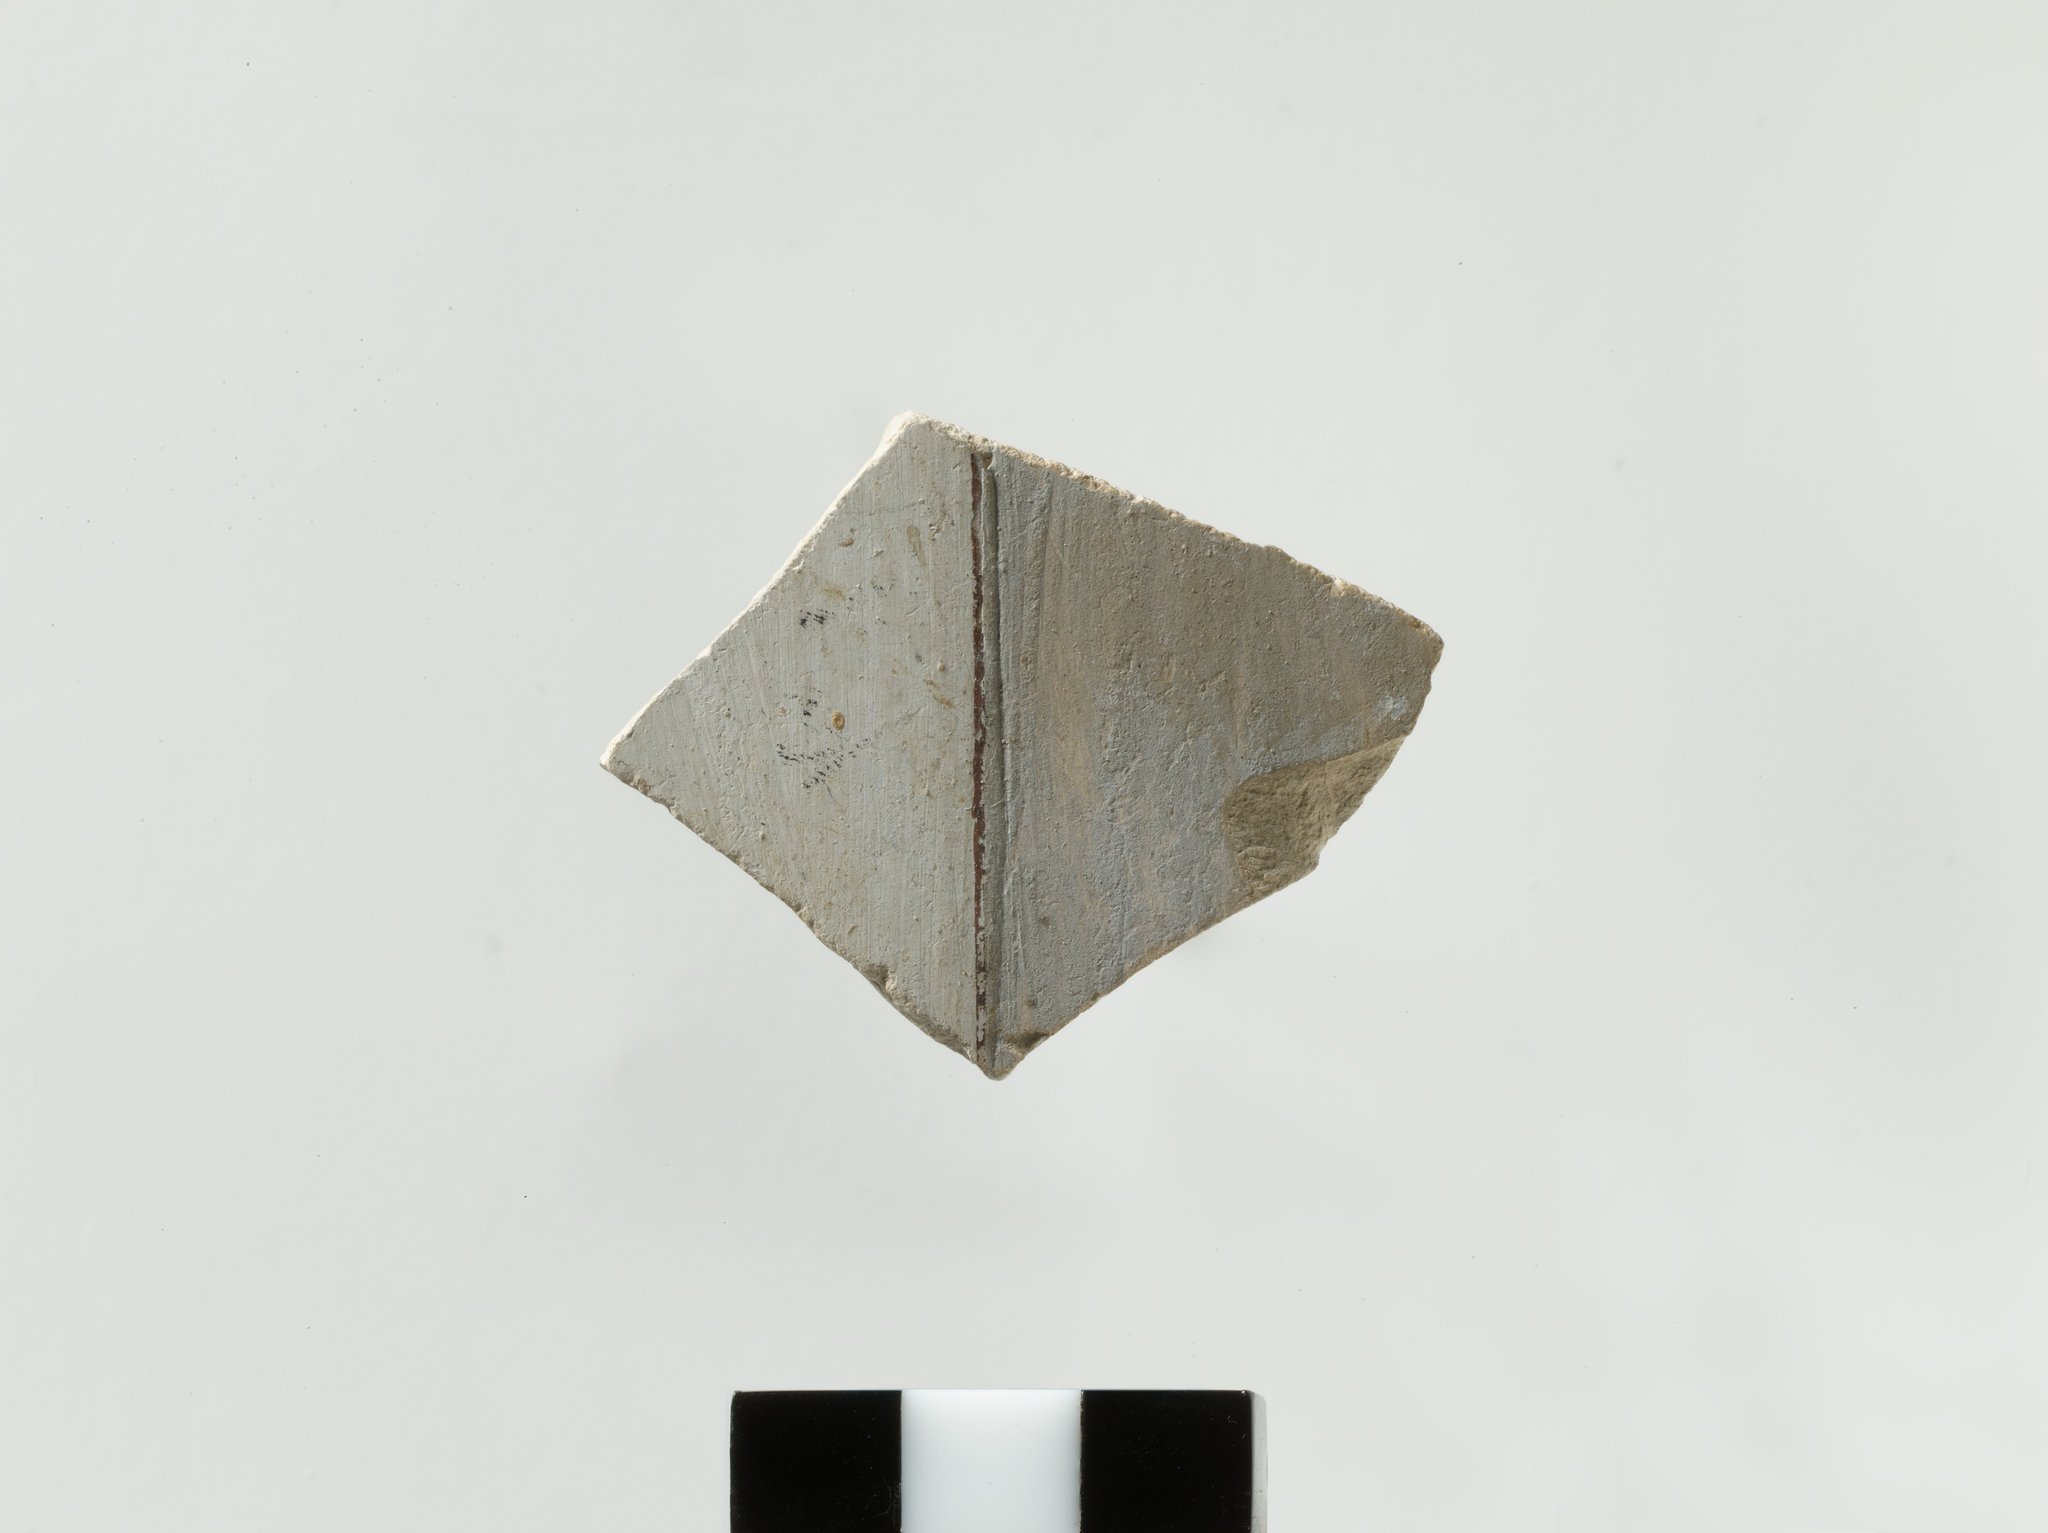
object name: relief fragment, tomb of meketre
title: Relief fragment from tomb of Meketre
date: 1981-1975 BCE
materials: limestone, paint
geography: egypt